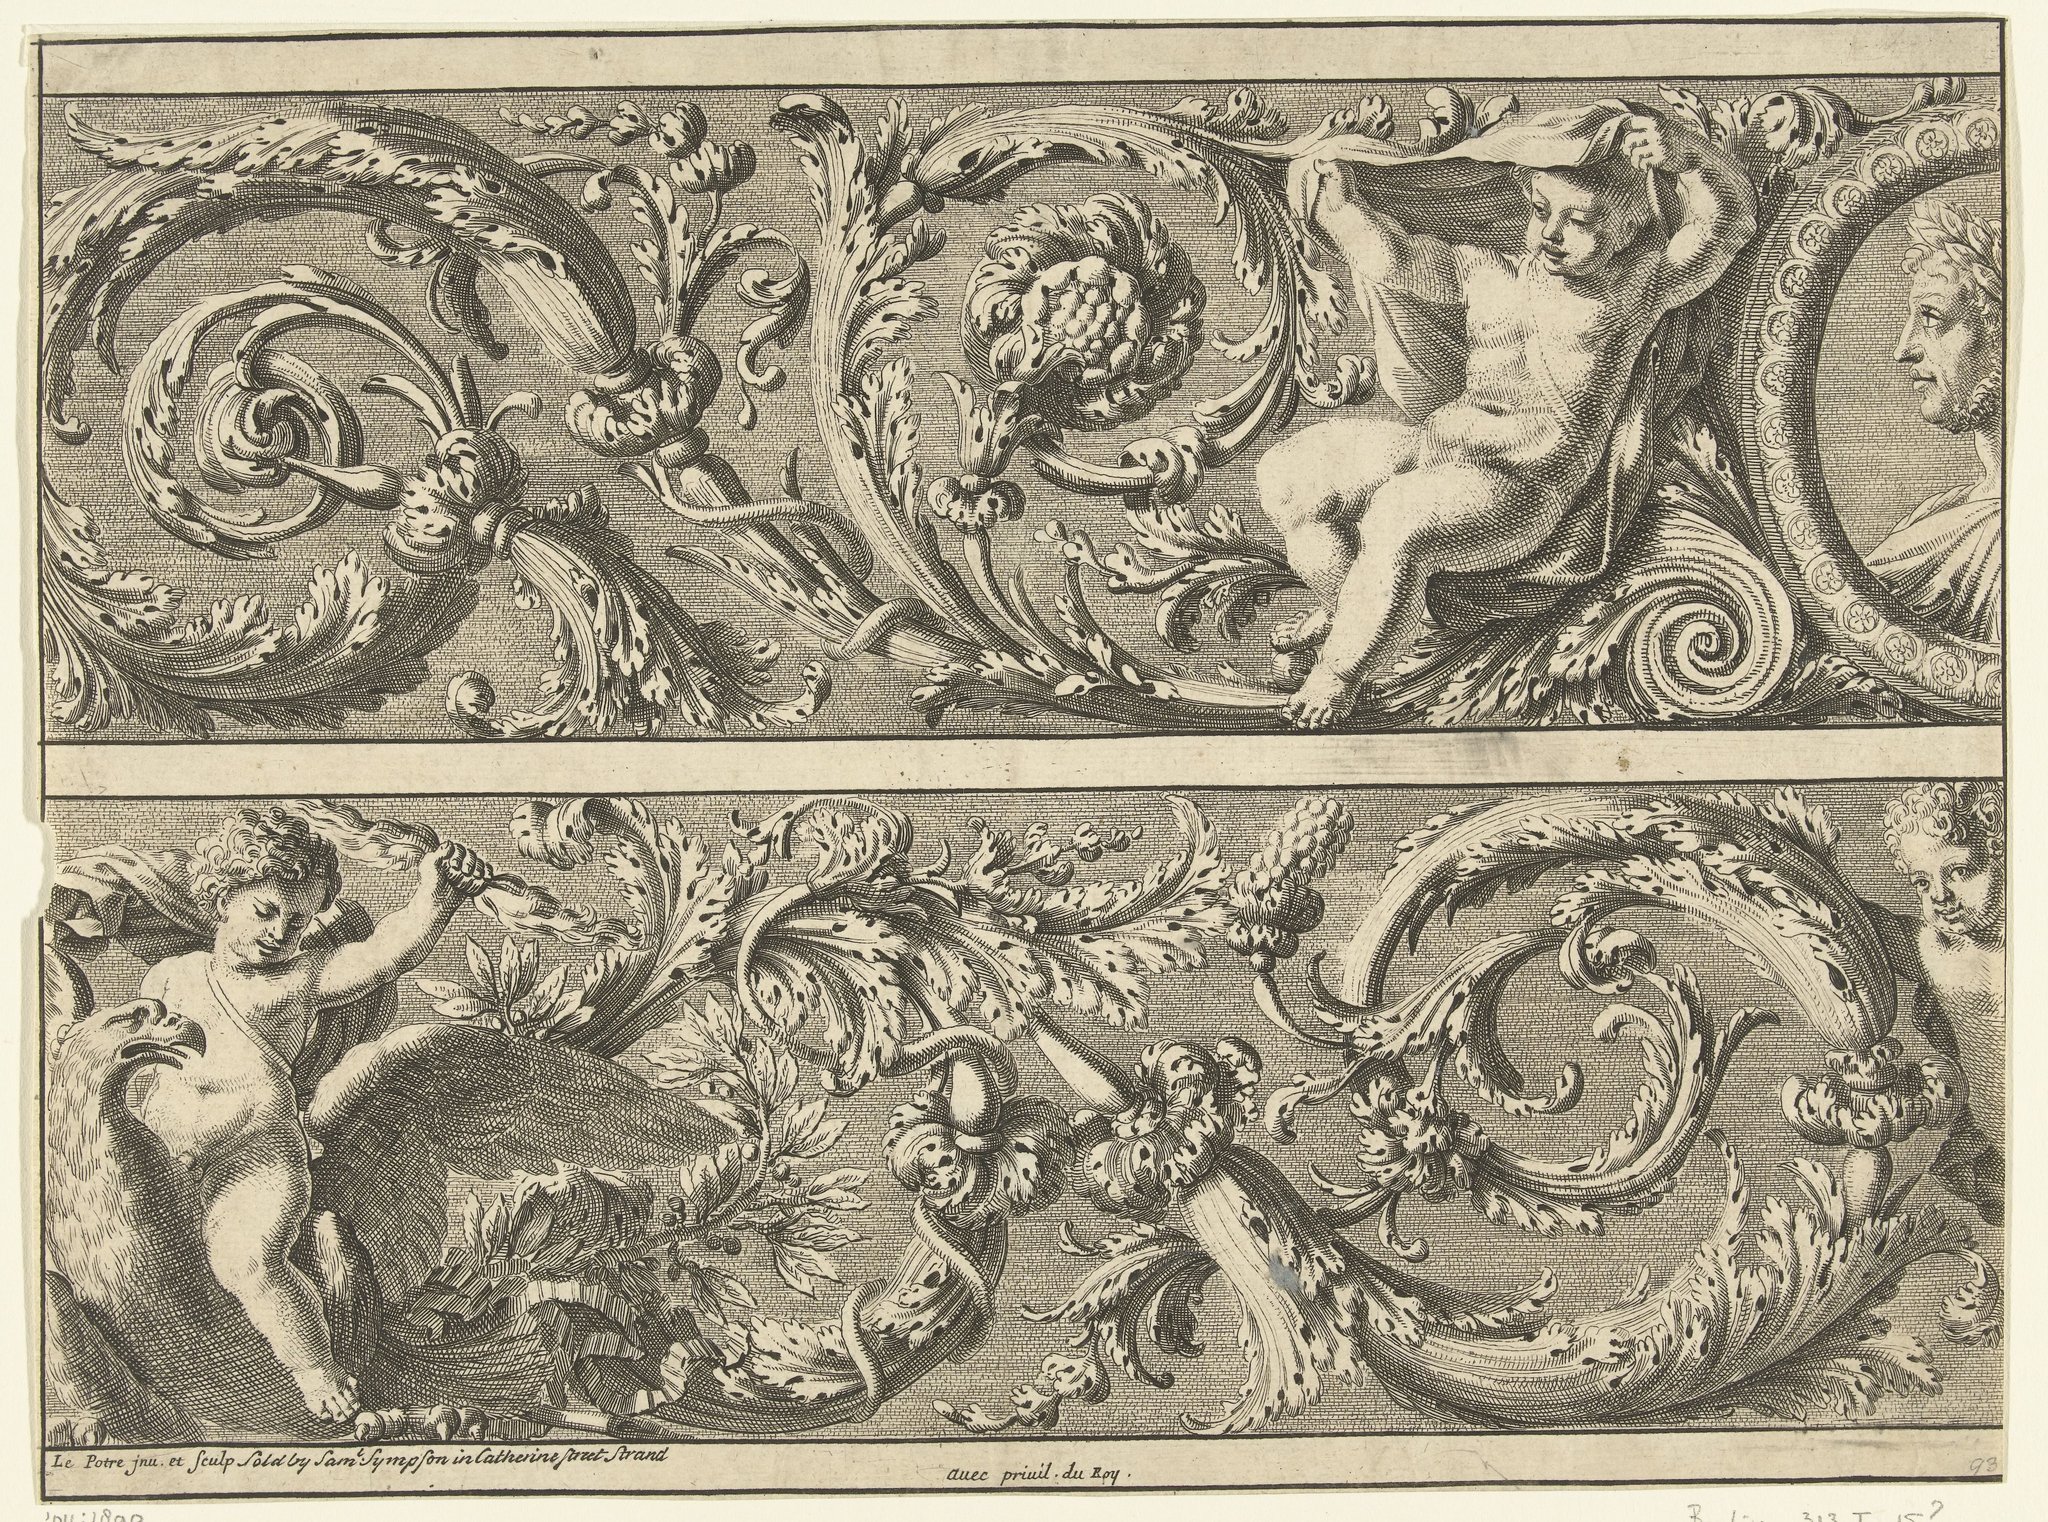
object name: ornament print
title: Friezen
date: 1731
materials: paper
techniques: etching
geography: london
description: Aan de rechterkant van het bovenste fries bevindt zich een half medaillon, aan de linkerkant van het onderste zit een putto op een adelaar. Blad uit serie van 6, derde editie.